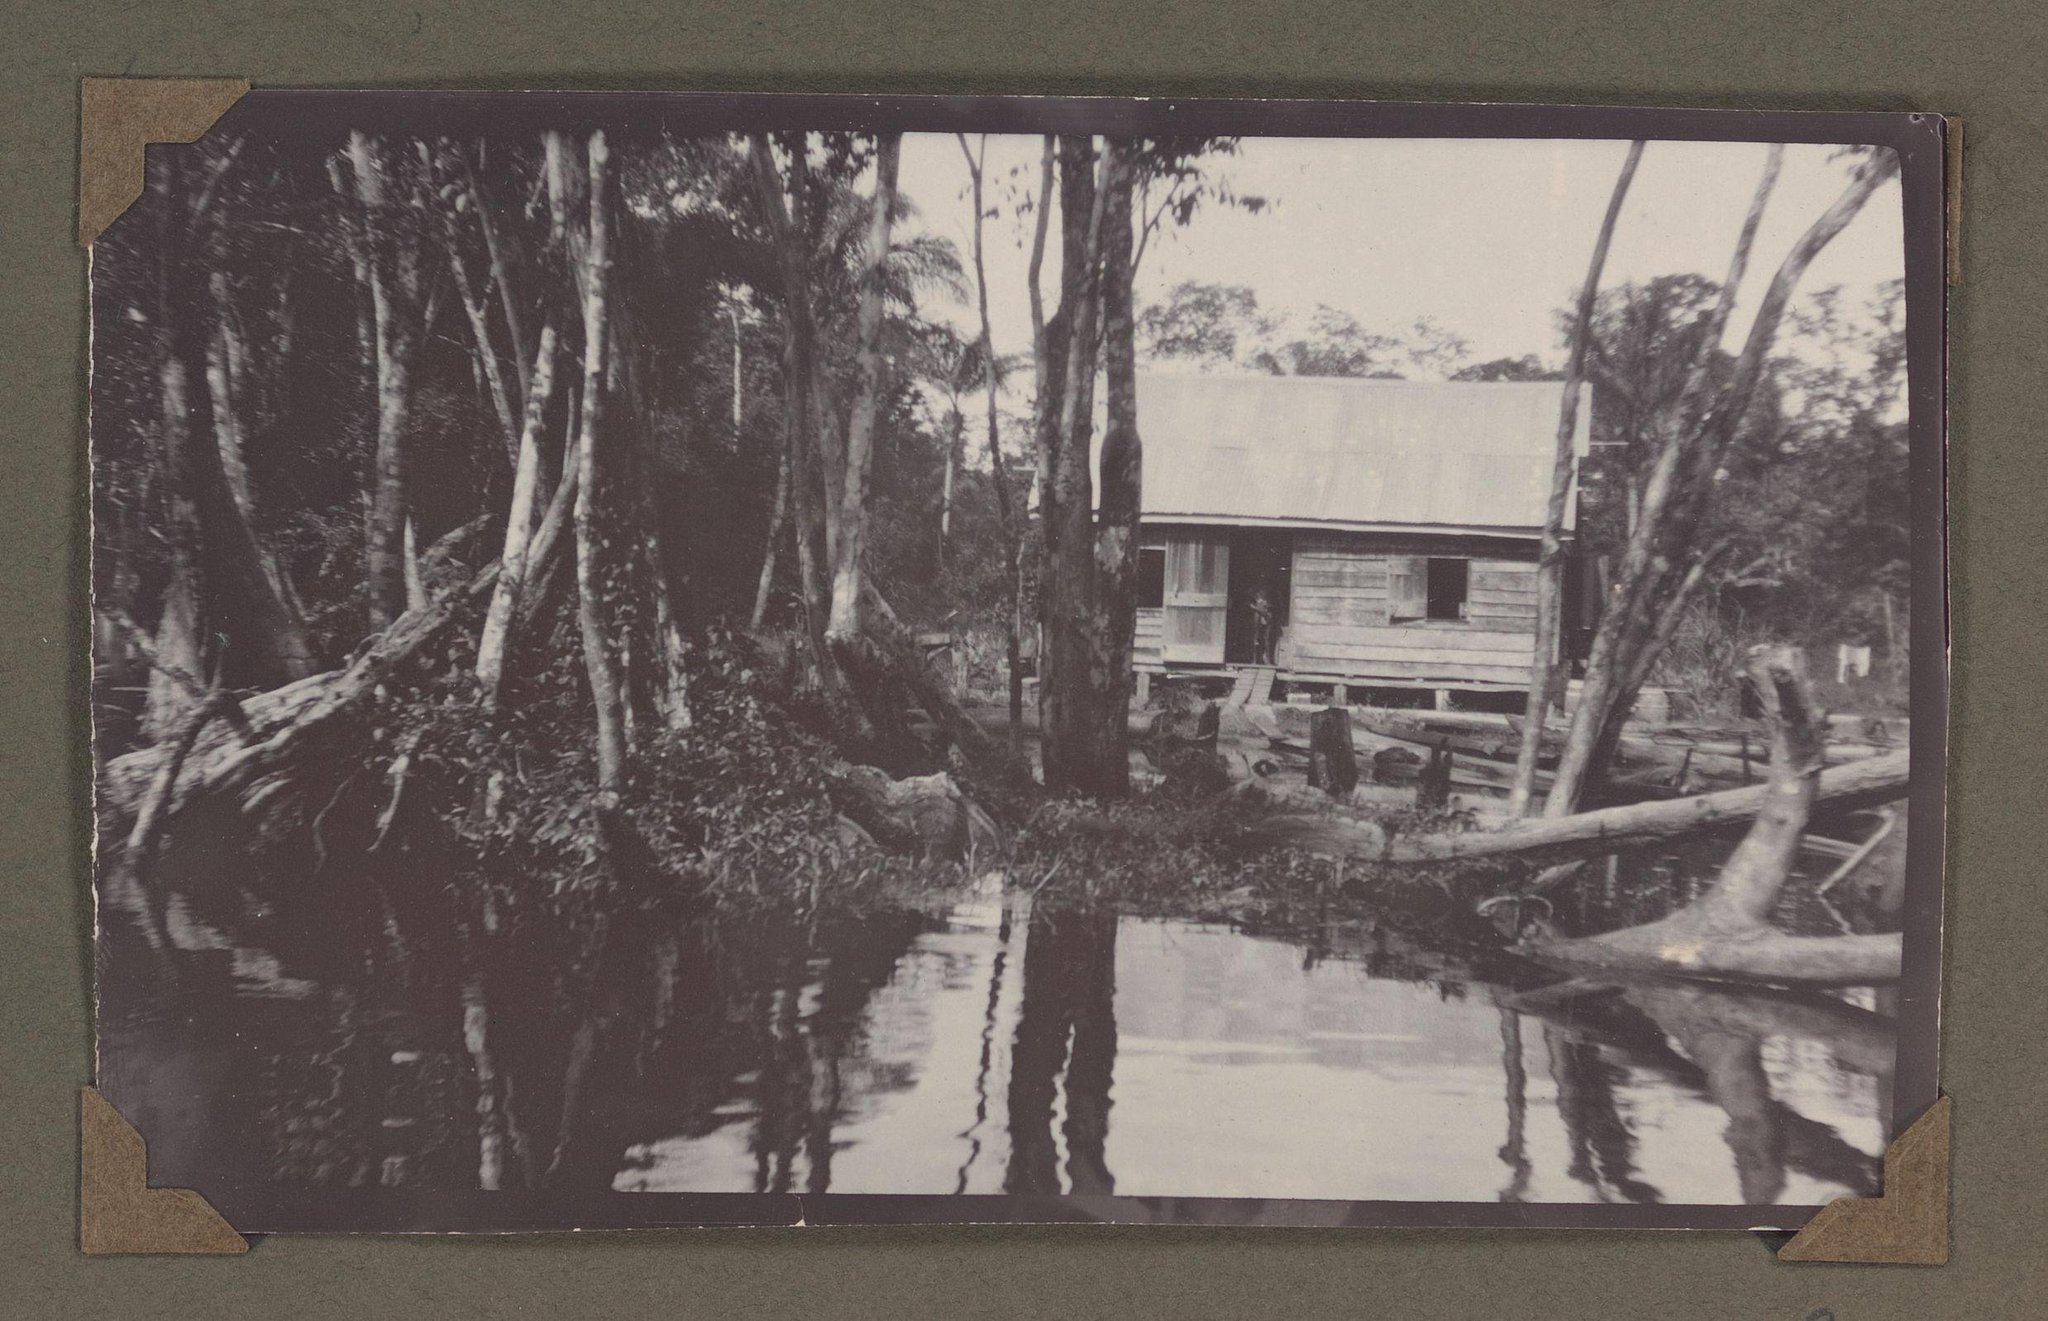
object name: photograph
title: Hut aan de rivier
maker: Anonymous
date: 1925-1927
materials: photographic support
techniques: photography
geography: suriname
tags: jetten, familie, moengo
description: Hut aan de rivier. Foto op een bladzijde van een los albumblad. Onderdeel van het ensemble met foto's van de familie van ingenieur Jetten in de mijnbouwstad Moengo in Suriname.